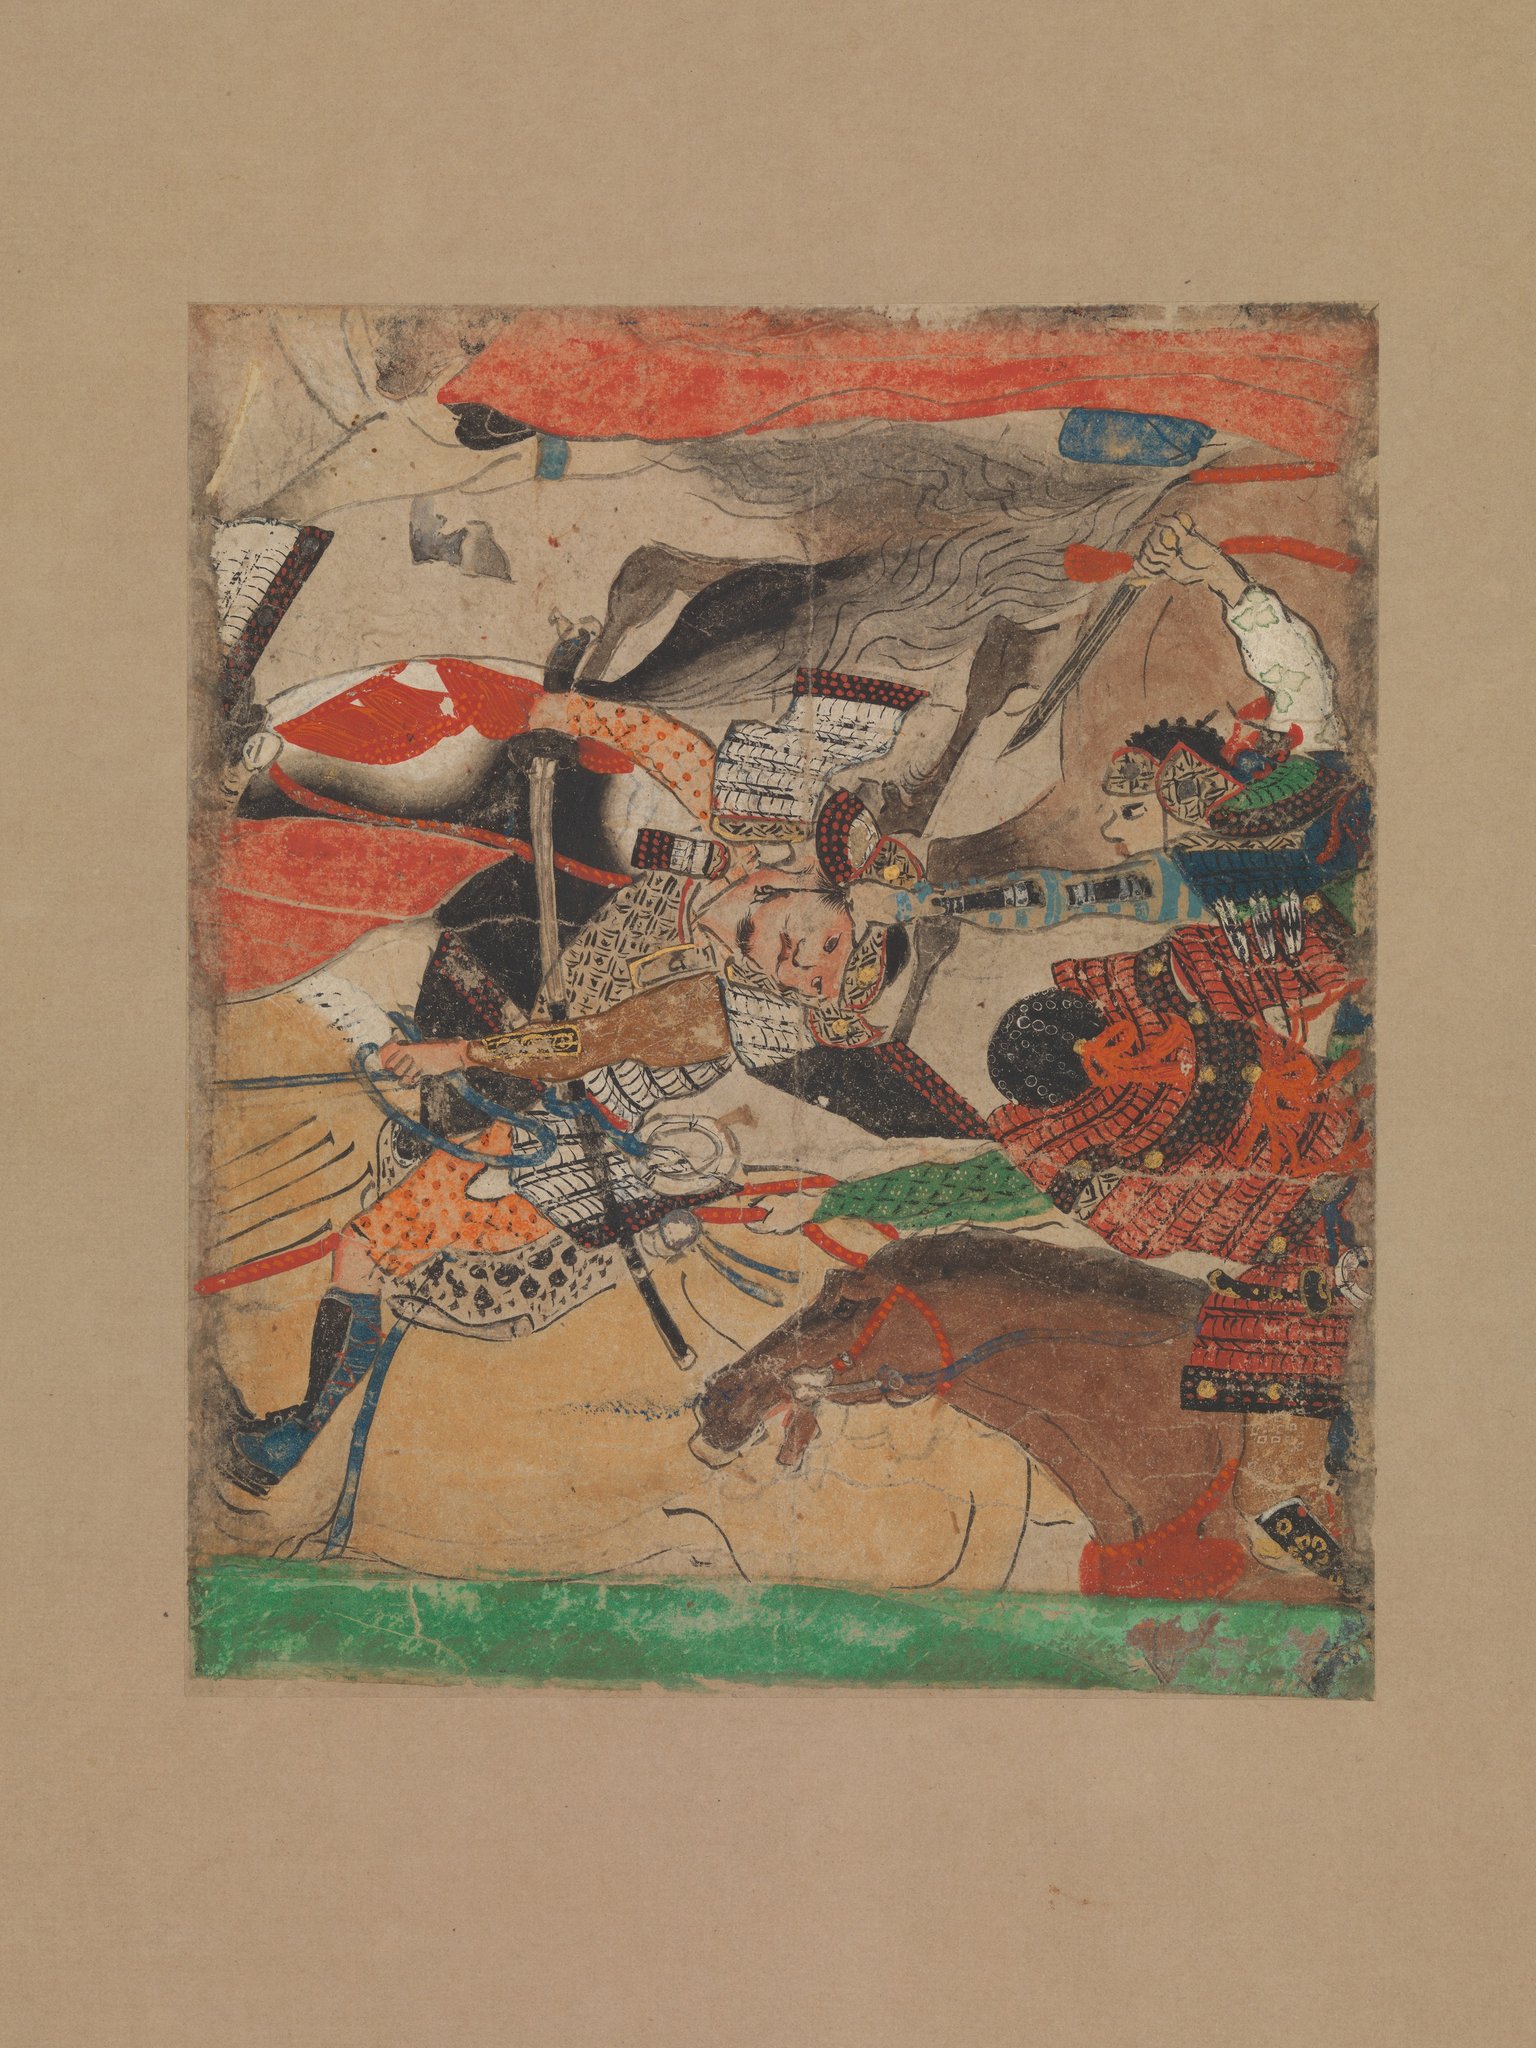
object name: hanging scroll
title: Battle at Rokuhara, from The Tale of the Heiji Rebellion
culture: japanese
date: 1301-1325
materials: gold, ink, paper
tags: battles,swords,men,horses